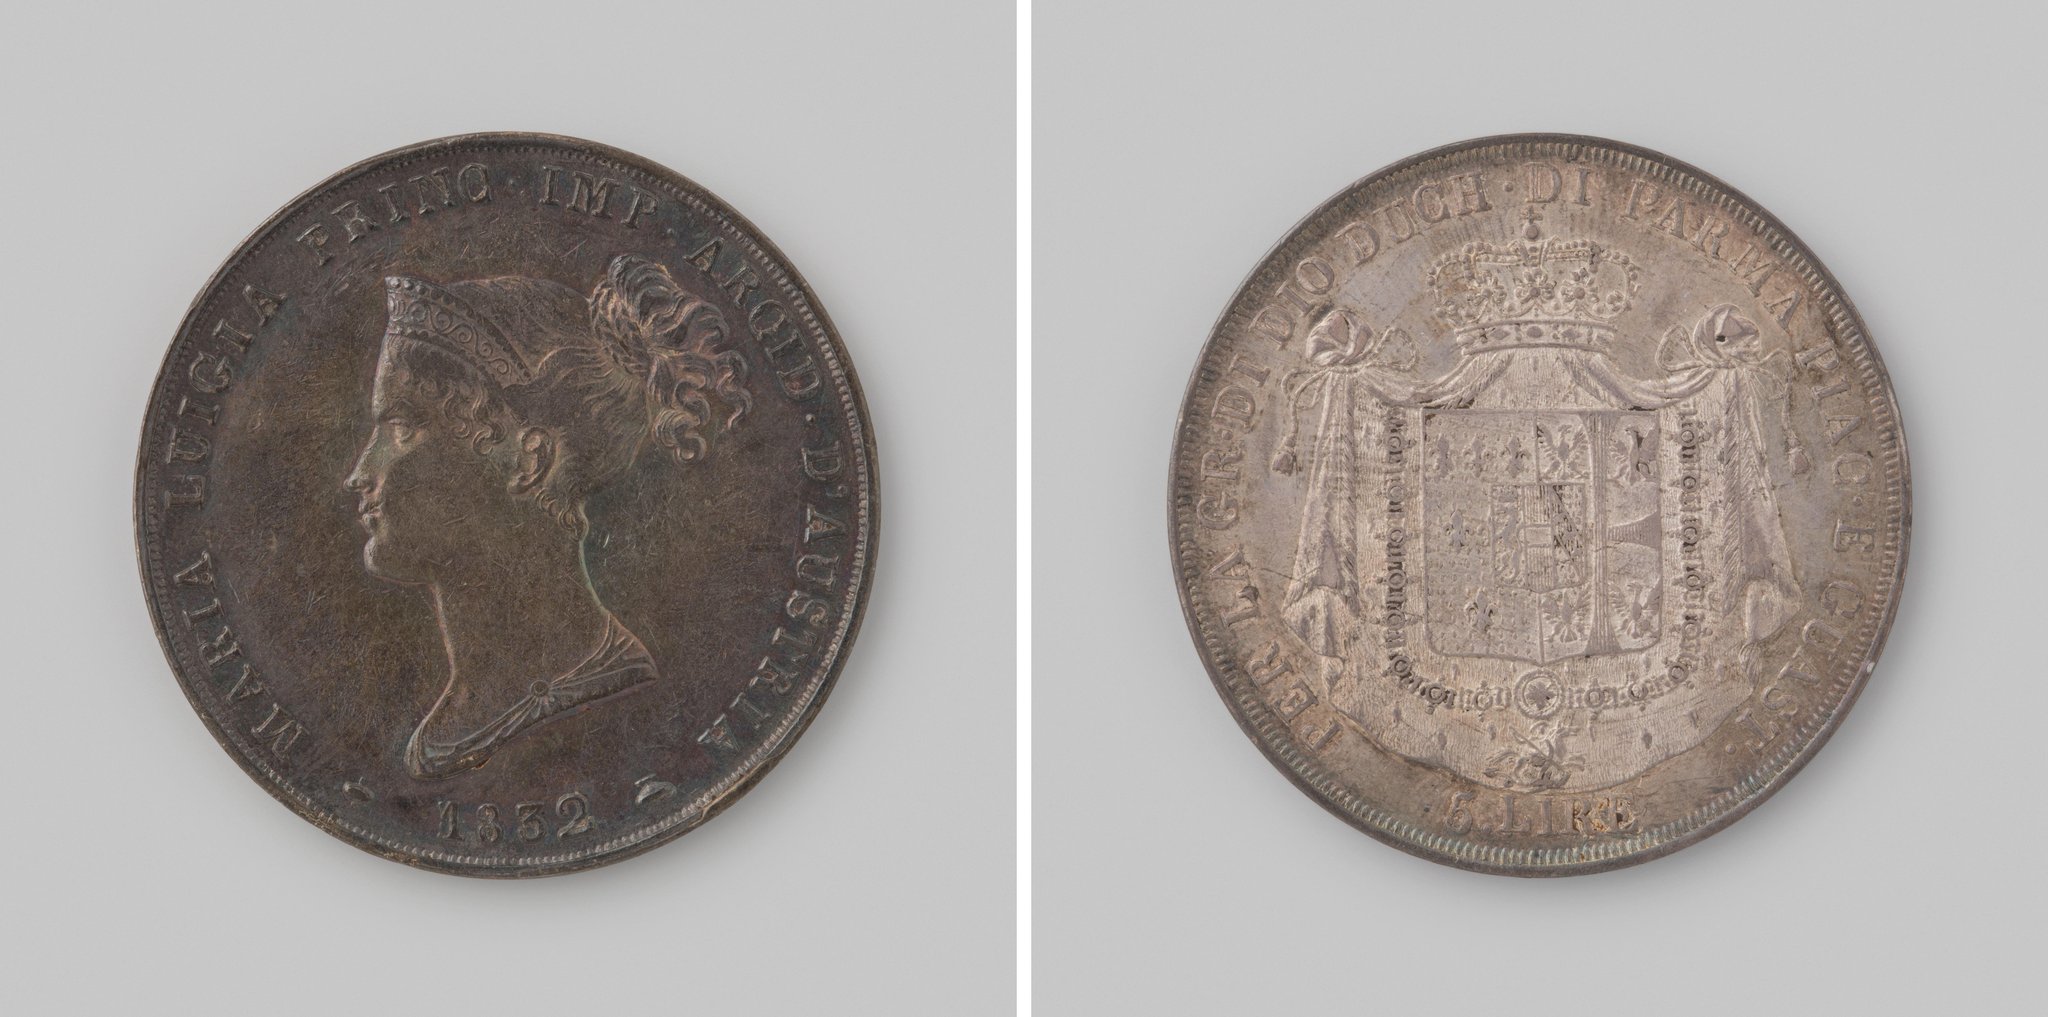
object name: coin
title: Hertogdom Parma, Maria Louisa, 5 lire, 1832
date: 1832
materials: copper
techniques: striking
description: Zilveren munt. Voorzijde: hoofd van de hertogin met diadeem naar links. Jaartal onderaan. Keerzijde: gekroonde mantel, waarin door keten van ridderorde met juweeel omhangen samengesteld wapenschild. Waarde-aanduiding onderaan. Randschrift.